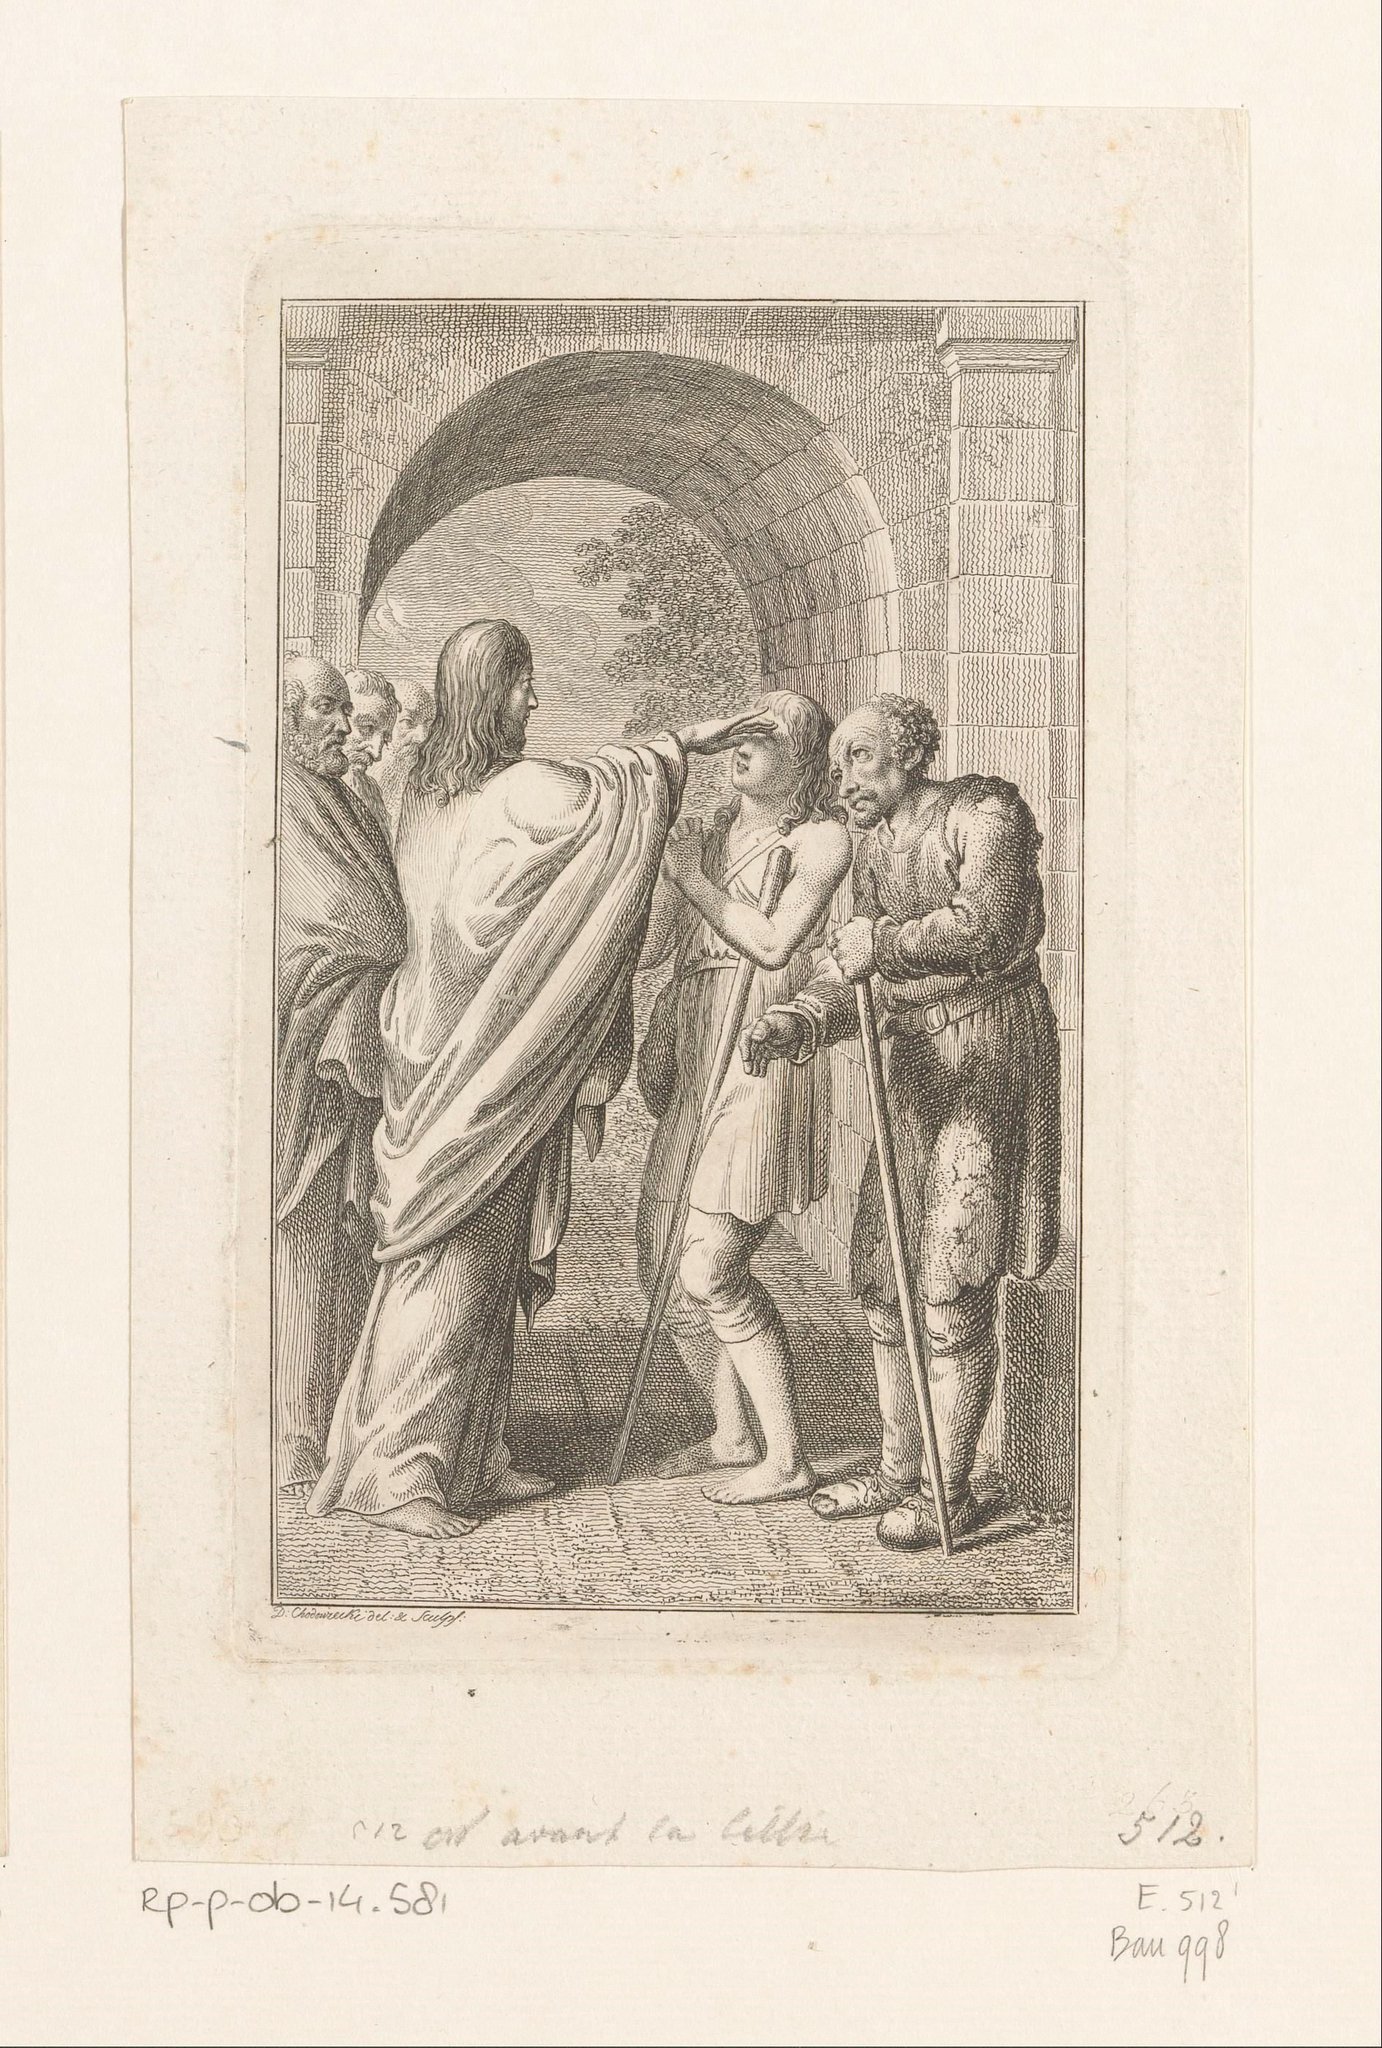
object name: print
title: Genezing van de blindgeborene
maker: daniel nikolaus chodowiecki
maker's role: draughtsman, print maker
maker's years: 1726-1801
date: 1784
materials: paper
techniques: etching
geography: berlin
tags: johann caspar lavater, healing of a man born blind: christ touches his eyes with an 'ointment' of dust and spittle (john 9)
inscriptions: collector's mark: Lugt 2228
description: Prent gebruikt voor: Lavater, Johann Caspar. Jesus Messias, Oder die Evangelien und die Apostelgeschichte in Gesängen. 4 dln. Winterthur: s.n., 1784, dl. 2.